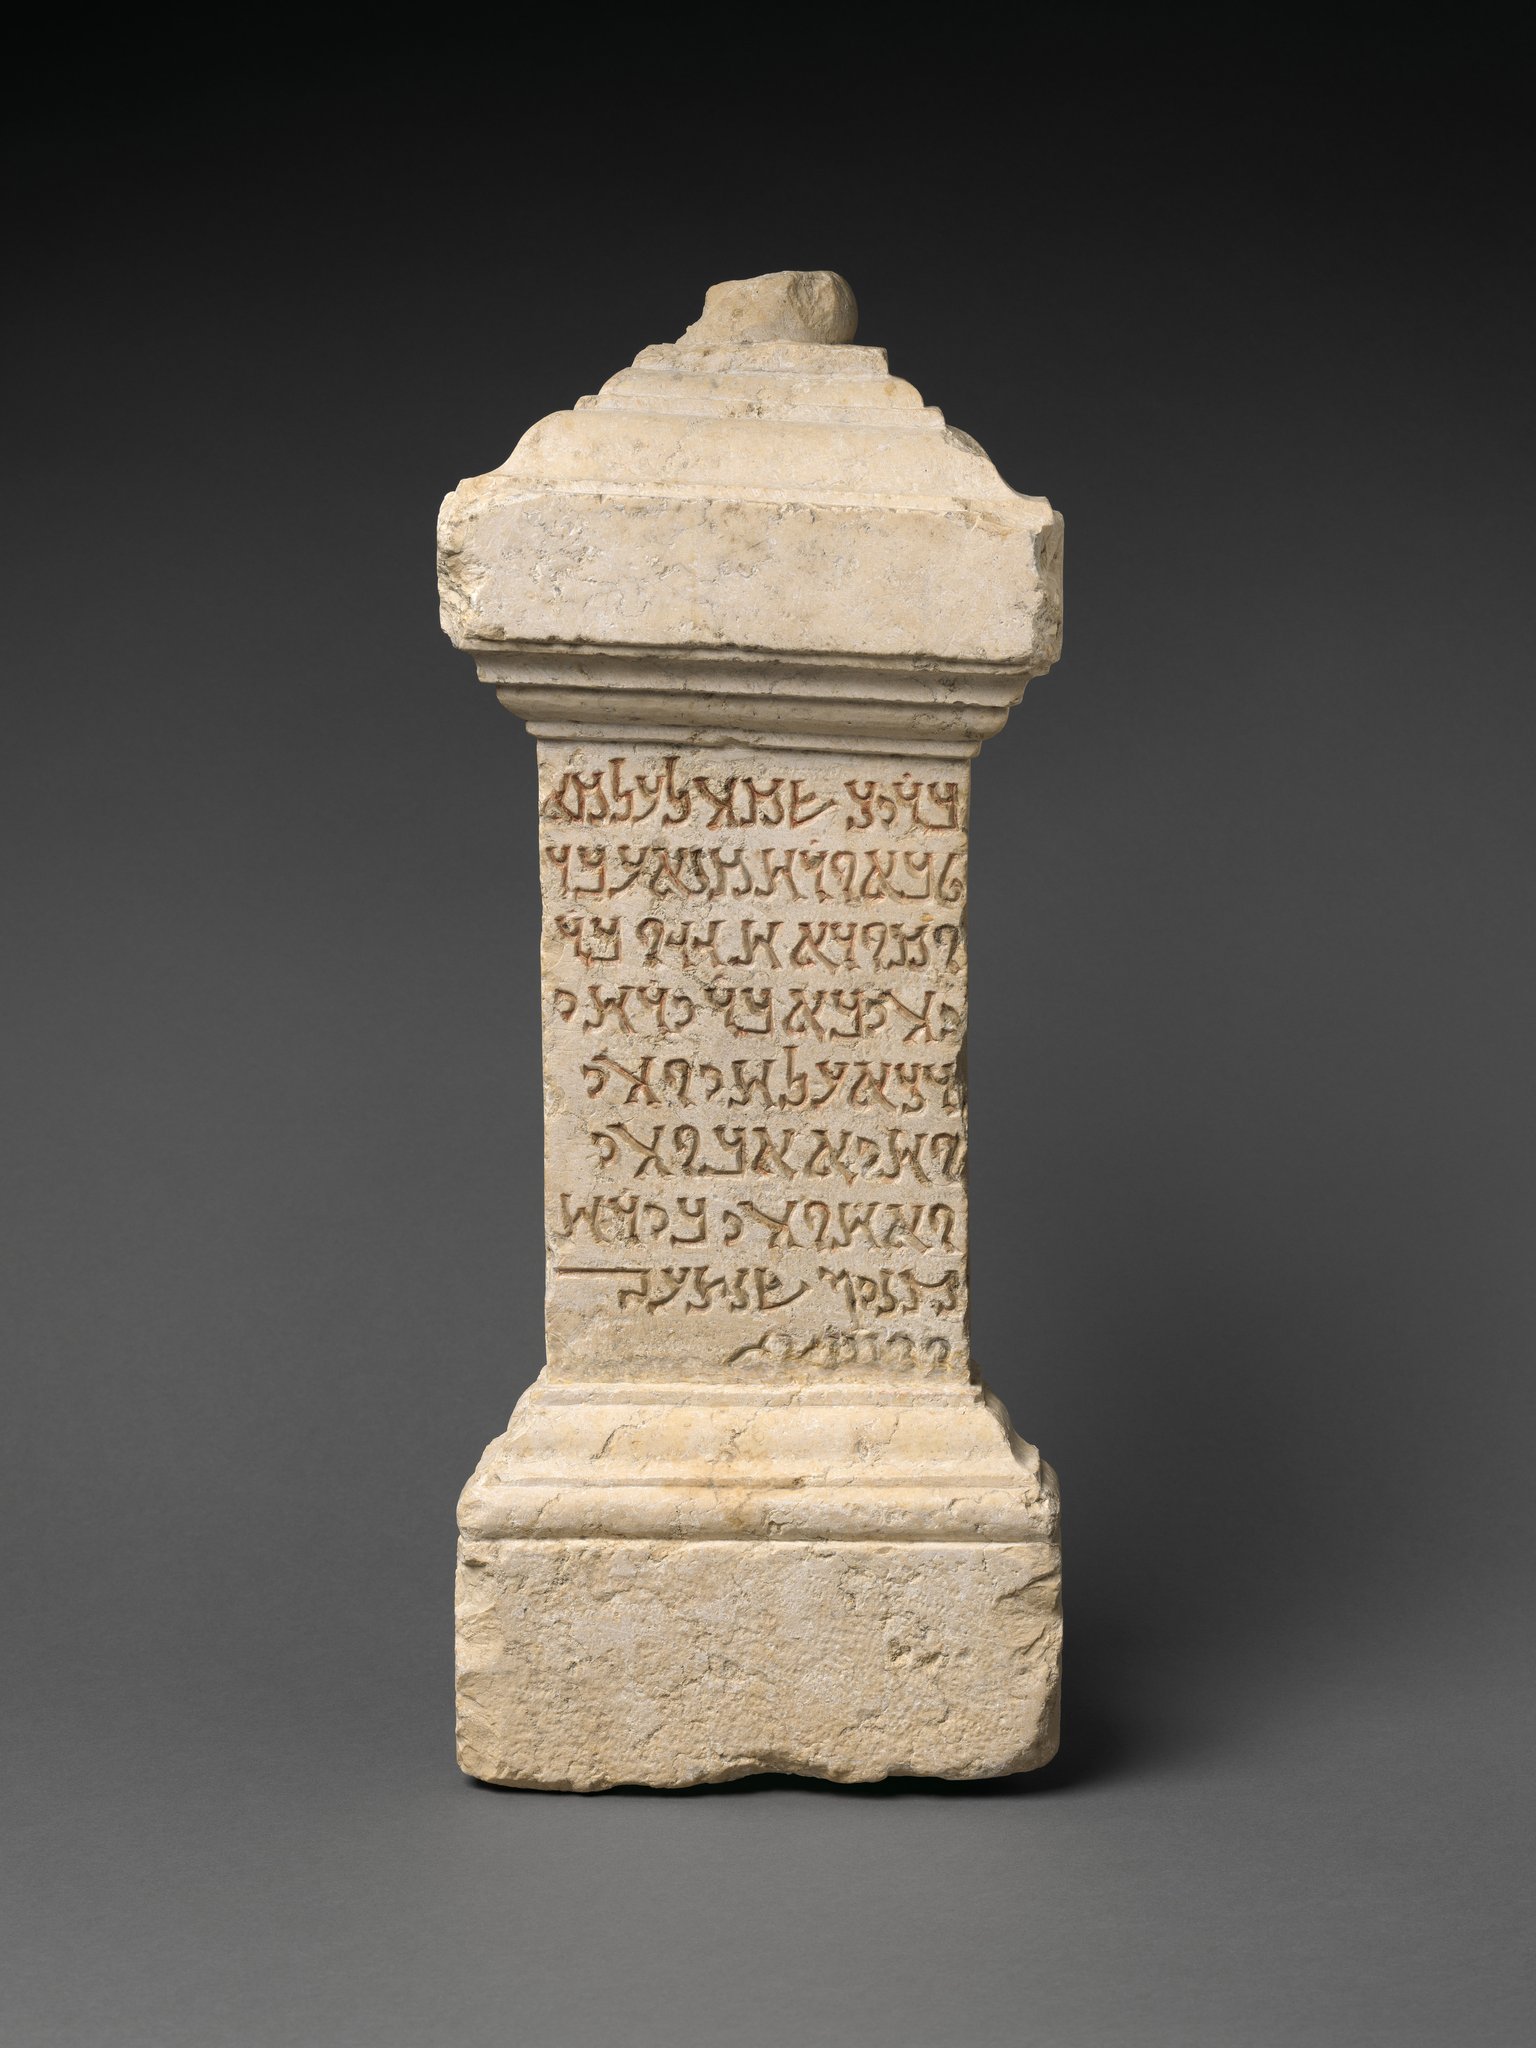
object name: altar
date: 232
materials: limestone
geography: syria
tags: altars